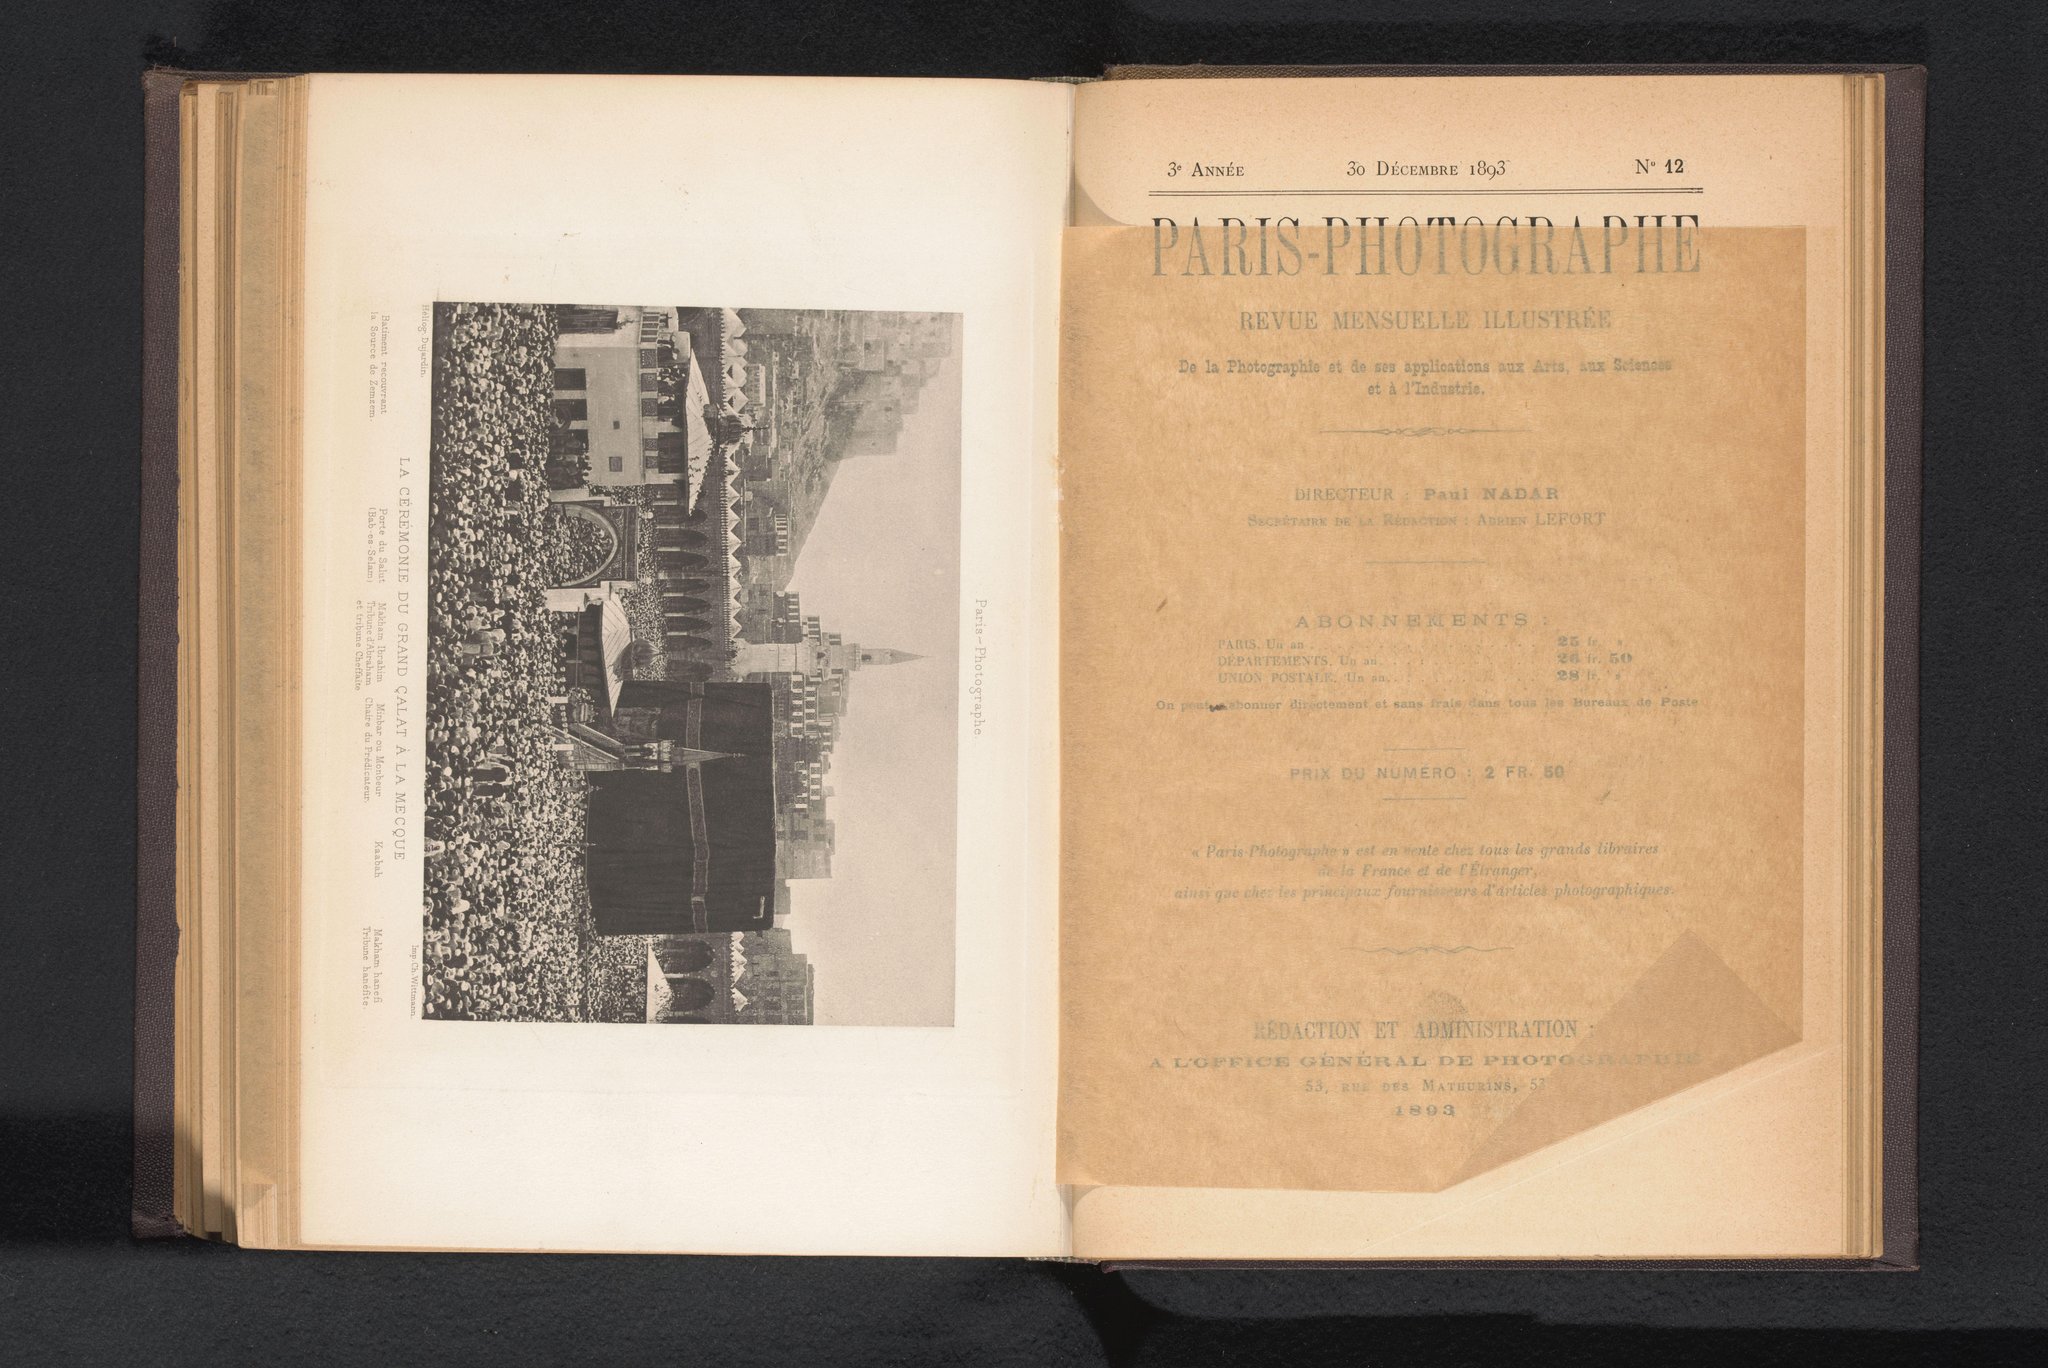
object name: photomechanical print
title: La cérémonie du grand Çalat à la Mecque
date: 1883-1893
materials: paper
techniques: photoaquatint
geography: france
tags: temple, shrine ~ islam, mohammedanism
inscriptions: inscription: ‘Batiment recouvrant (...) Tribune hanéfite’